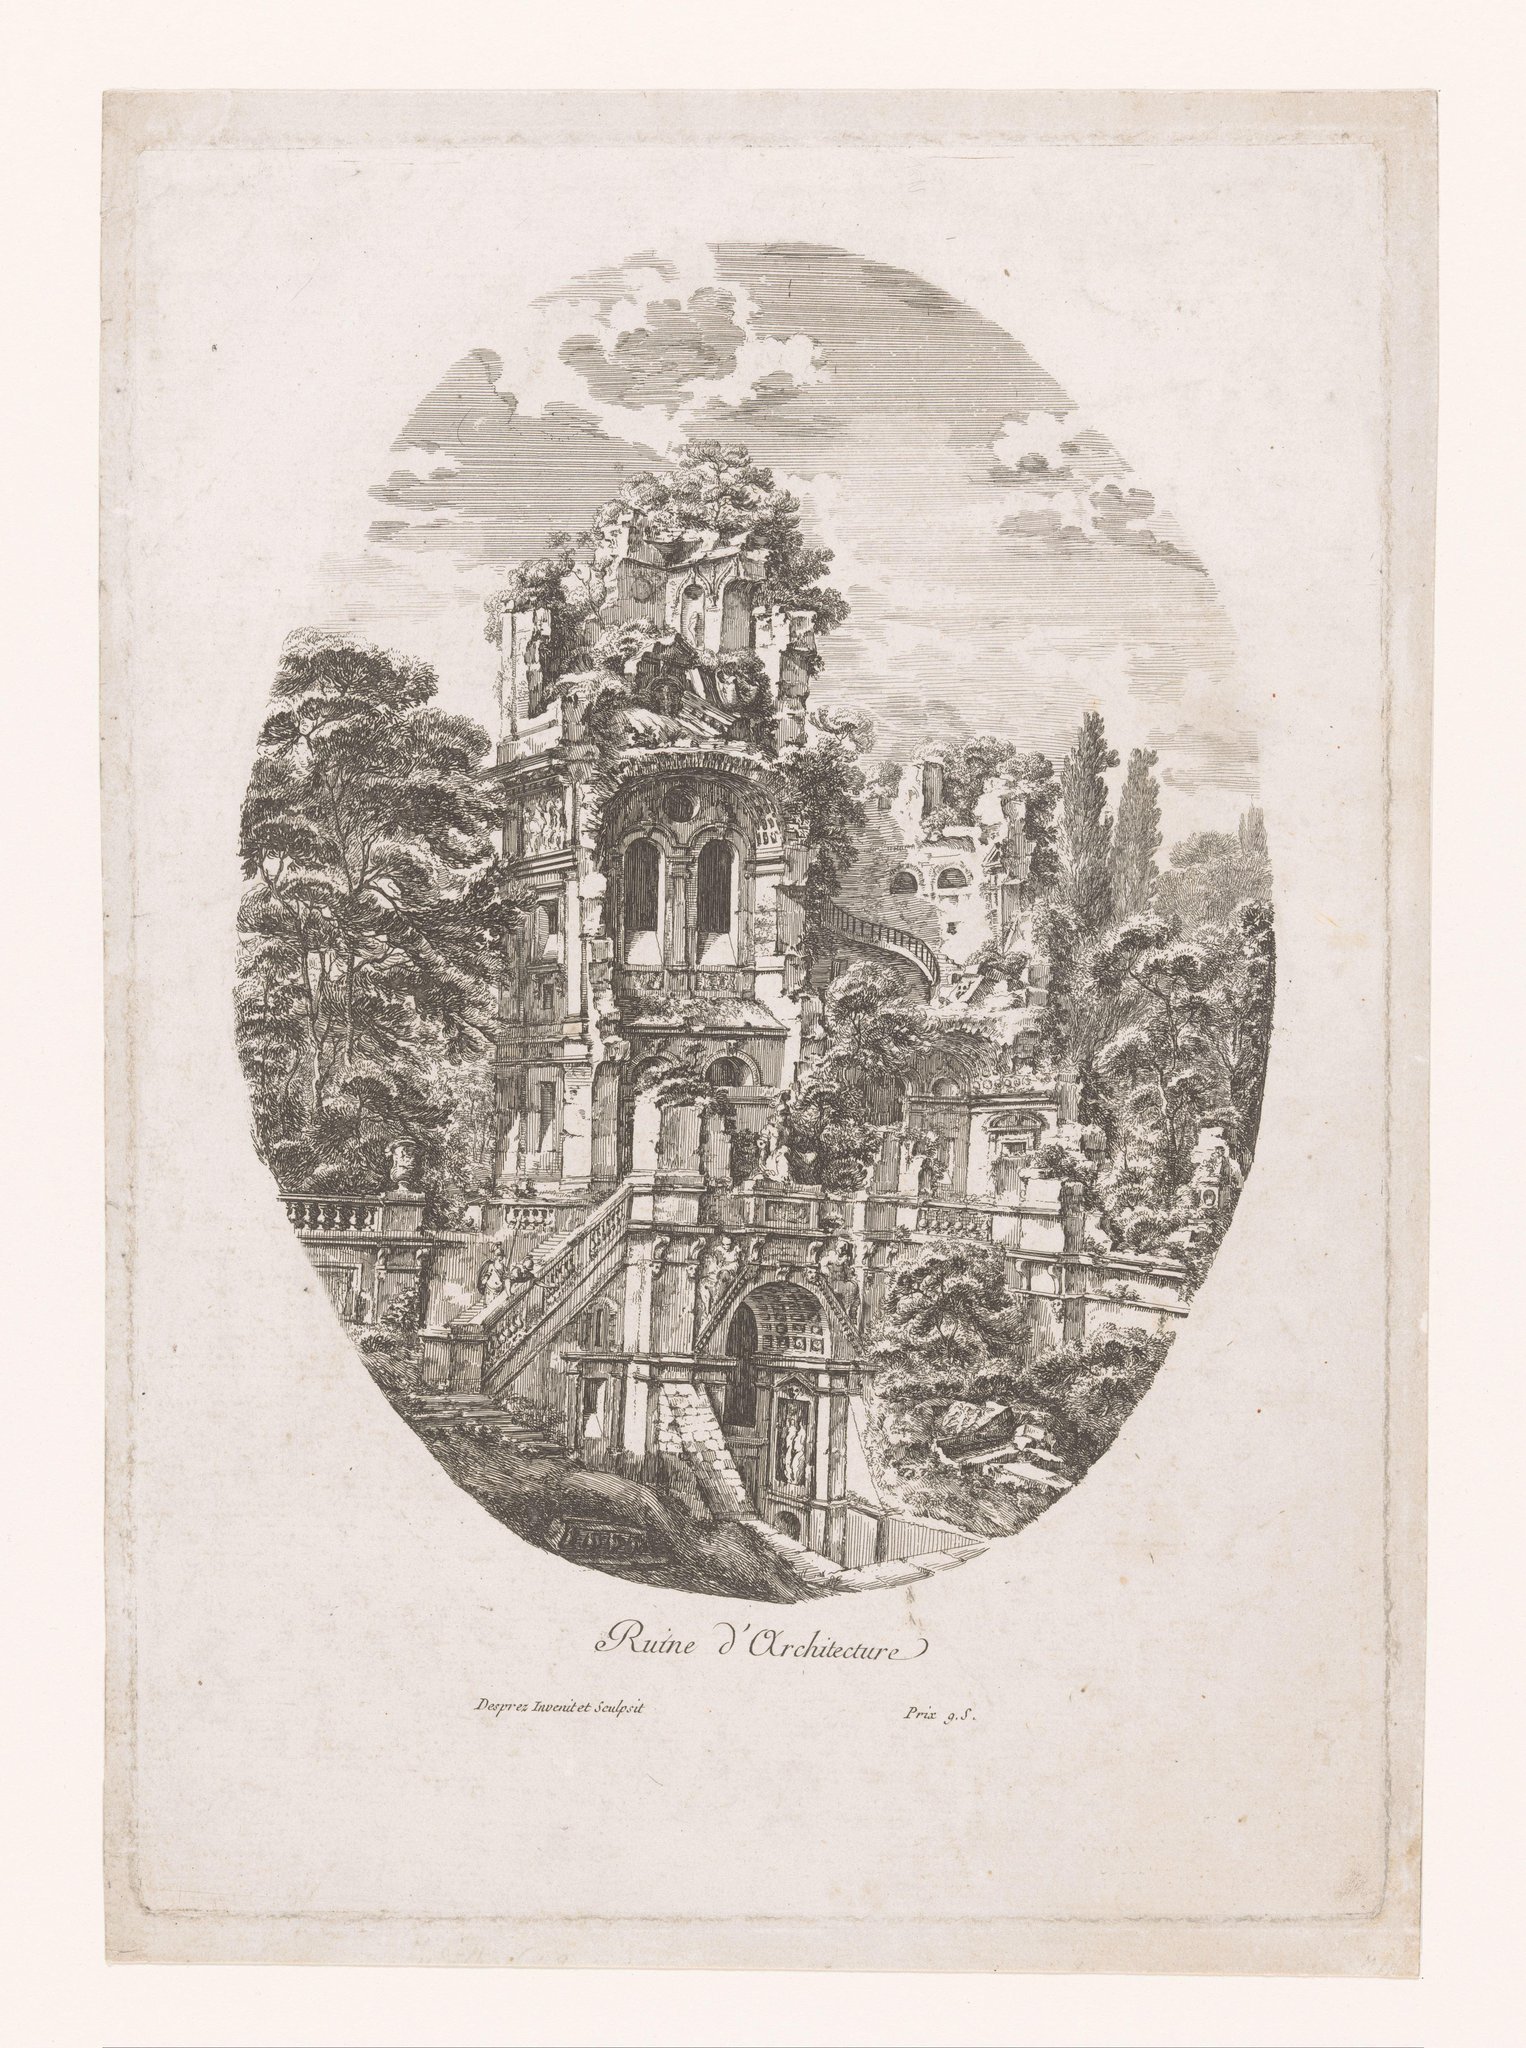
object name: print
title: <Capriccio> with Ruins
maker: louis jean desprez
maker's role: painter, print maker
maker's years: 1743-1804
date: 1771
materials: paper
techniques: etching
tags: ruin of a building ~ architecture, landscape with ruins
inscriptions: collector's mark: Lugt 2760, collector's mark: Lugt 2228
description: This charming etching is characteristic of Desprez’s early works made in France before his Italian sojourn. As a trained architect, he was able to combine elements of classical buildings in an imaginary composition, or < capriccio >. Lush vegetation has taken over this ruin, adding to its poetic appeal. Later on, Desprez would draw inspiration for his stage sets from such architectural fantasies.